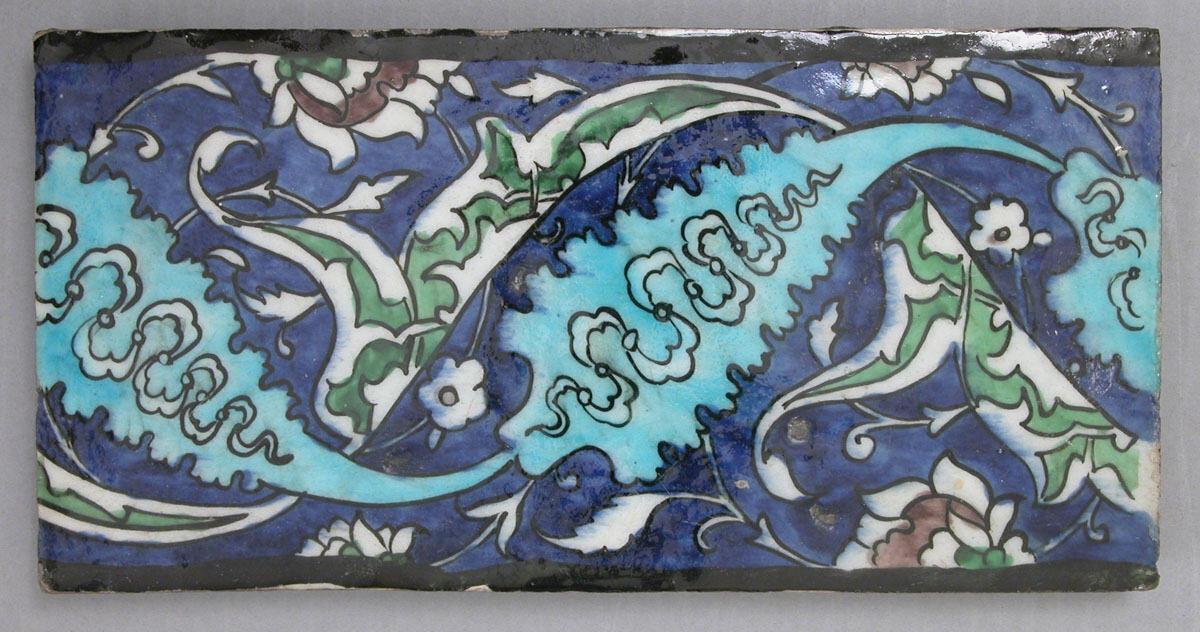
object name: tile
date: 1601-1700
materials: stonepaste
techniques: glazing, painting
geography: syria